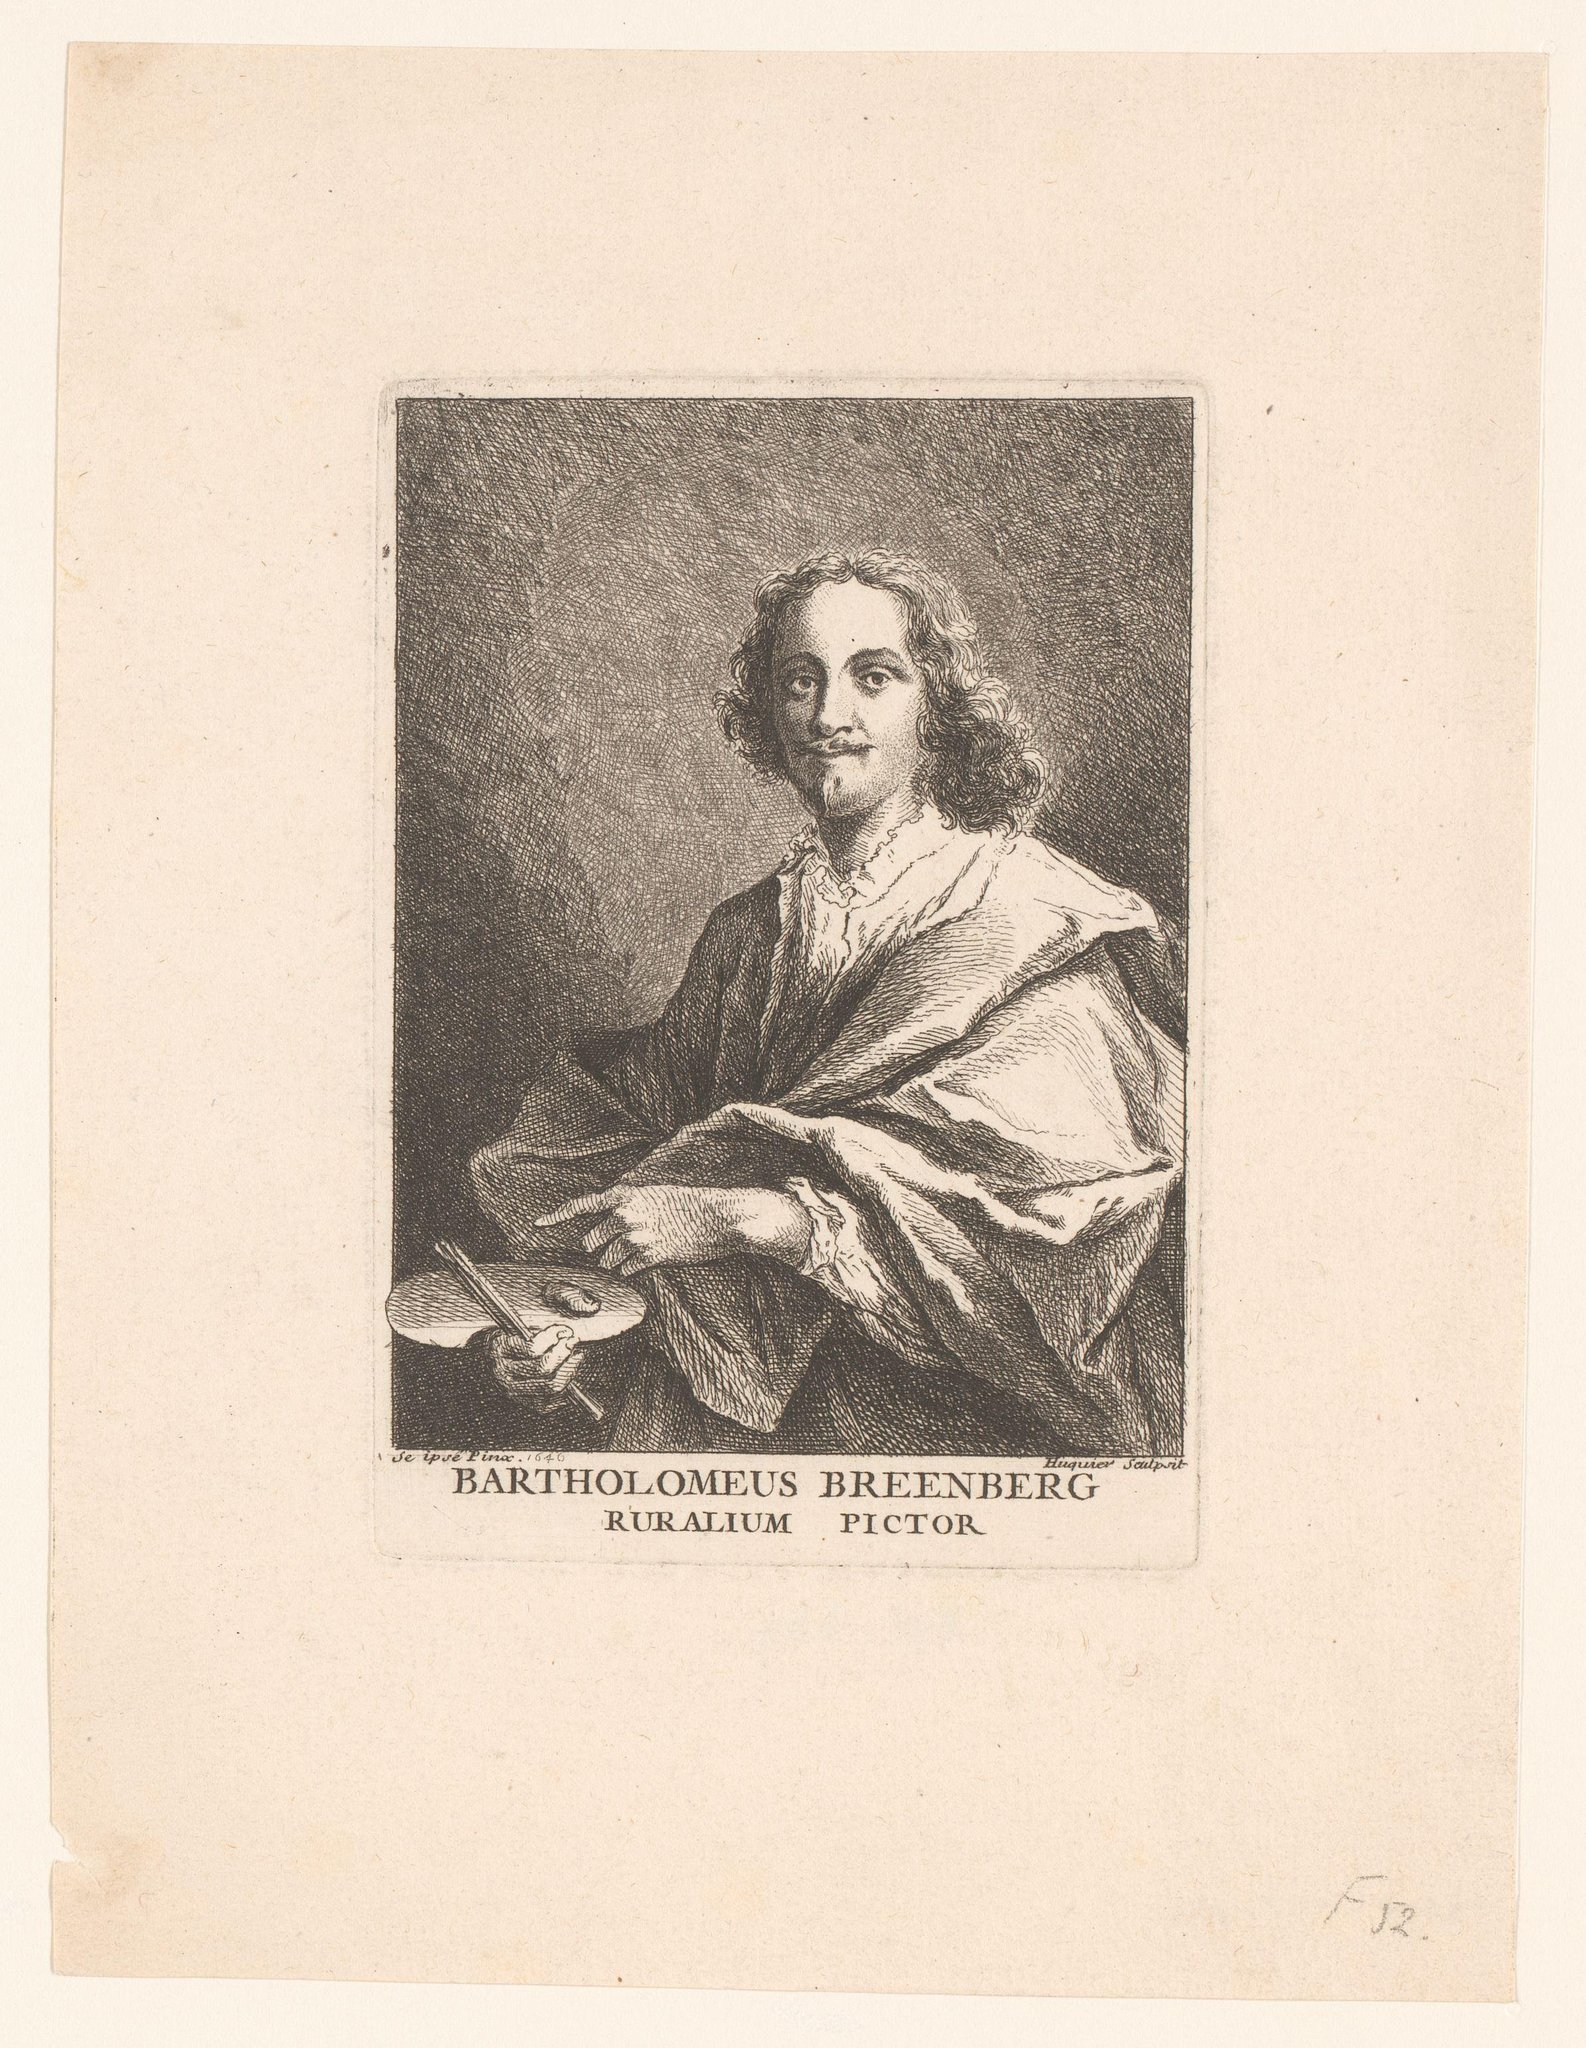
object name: print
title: Portret van Bartholomeus Breenbergh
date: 1705-1772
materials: paper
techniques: etching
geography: france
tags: deventer, amsterdam, print maker, draughtsman, bartholomeus breenbergh, historical persons, portrait, self-portrait of artist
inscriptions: collector's mark: Lugt 2228